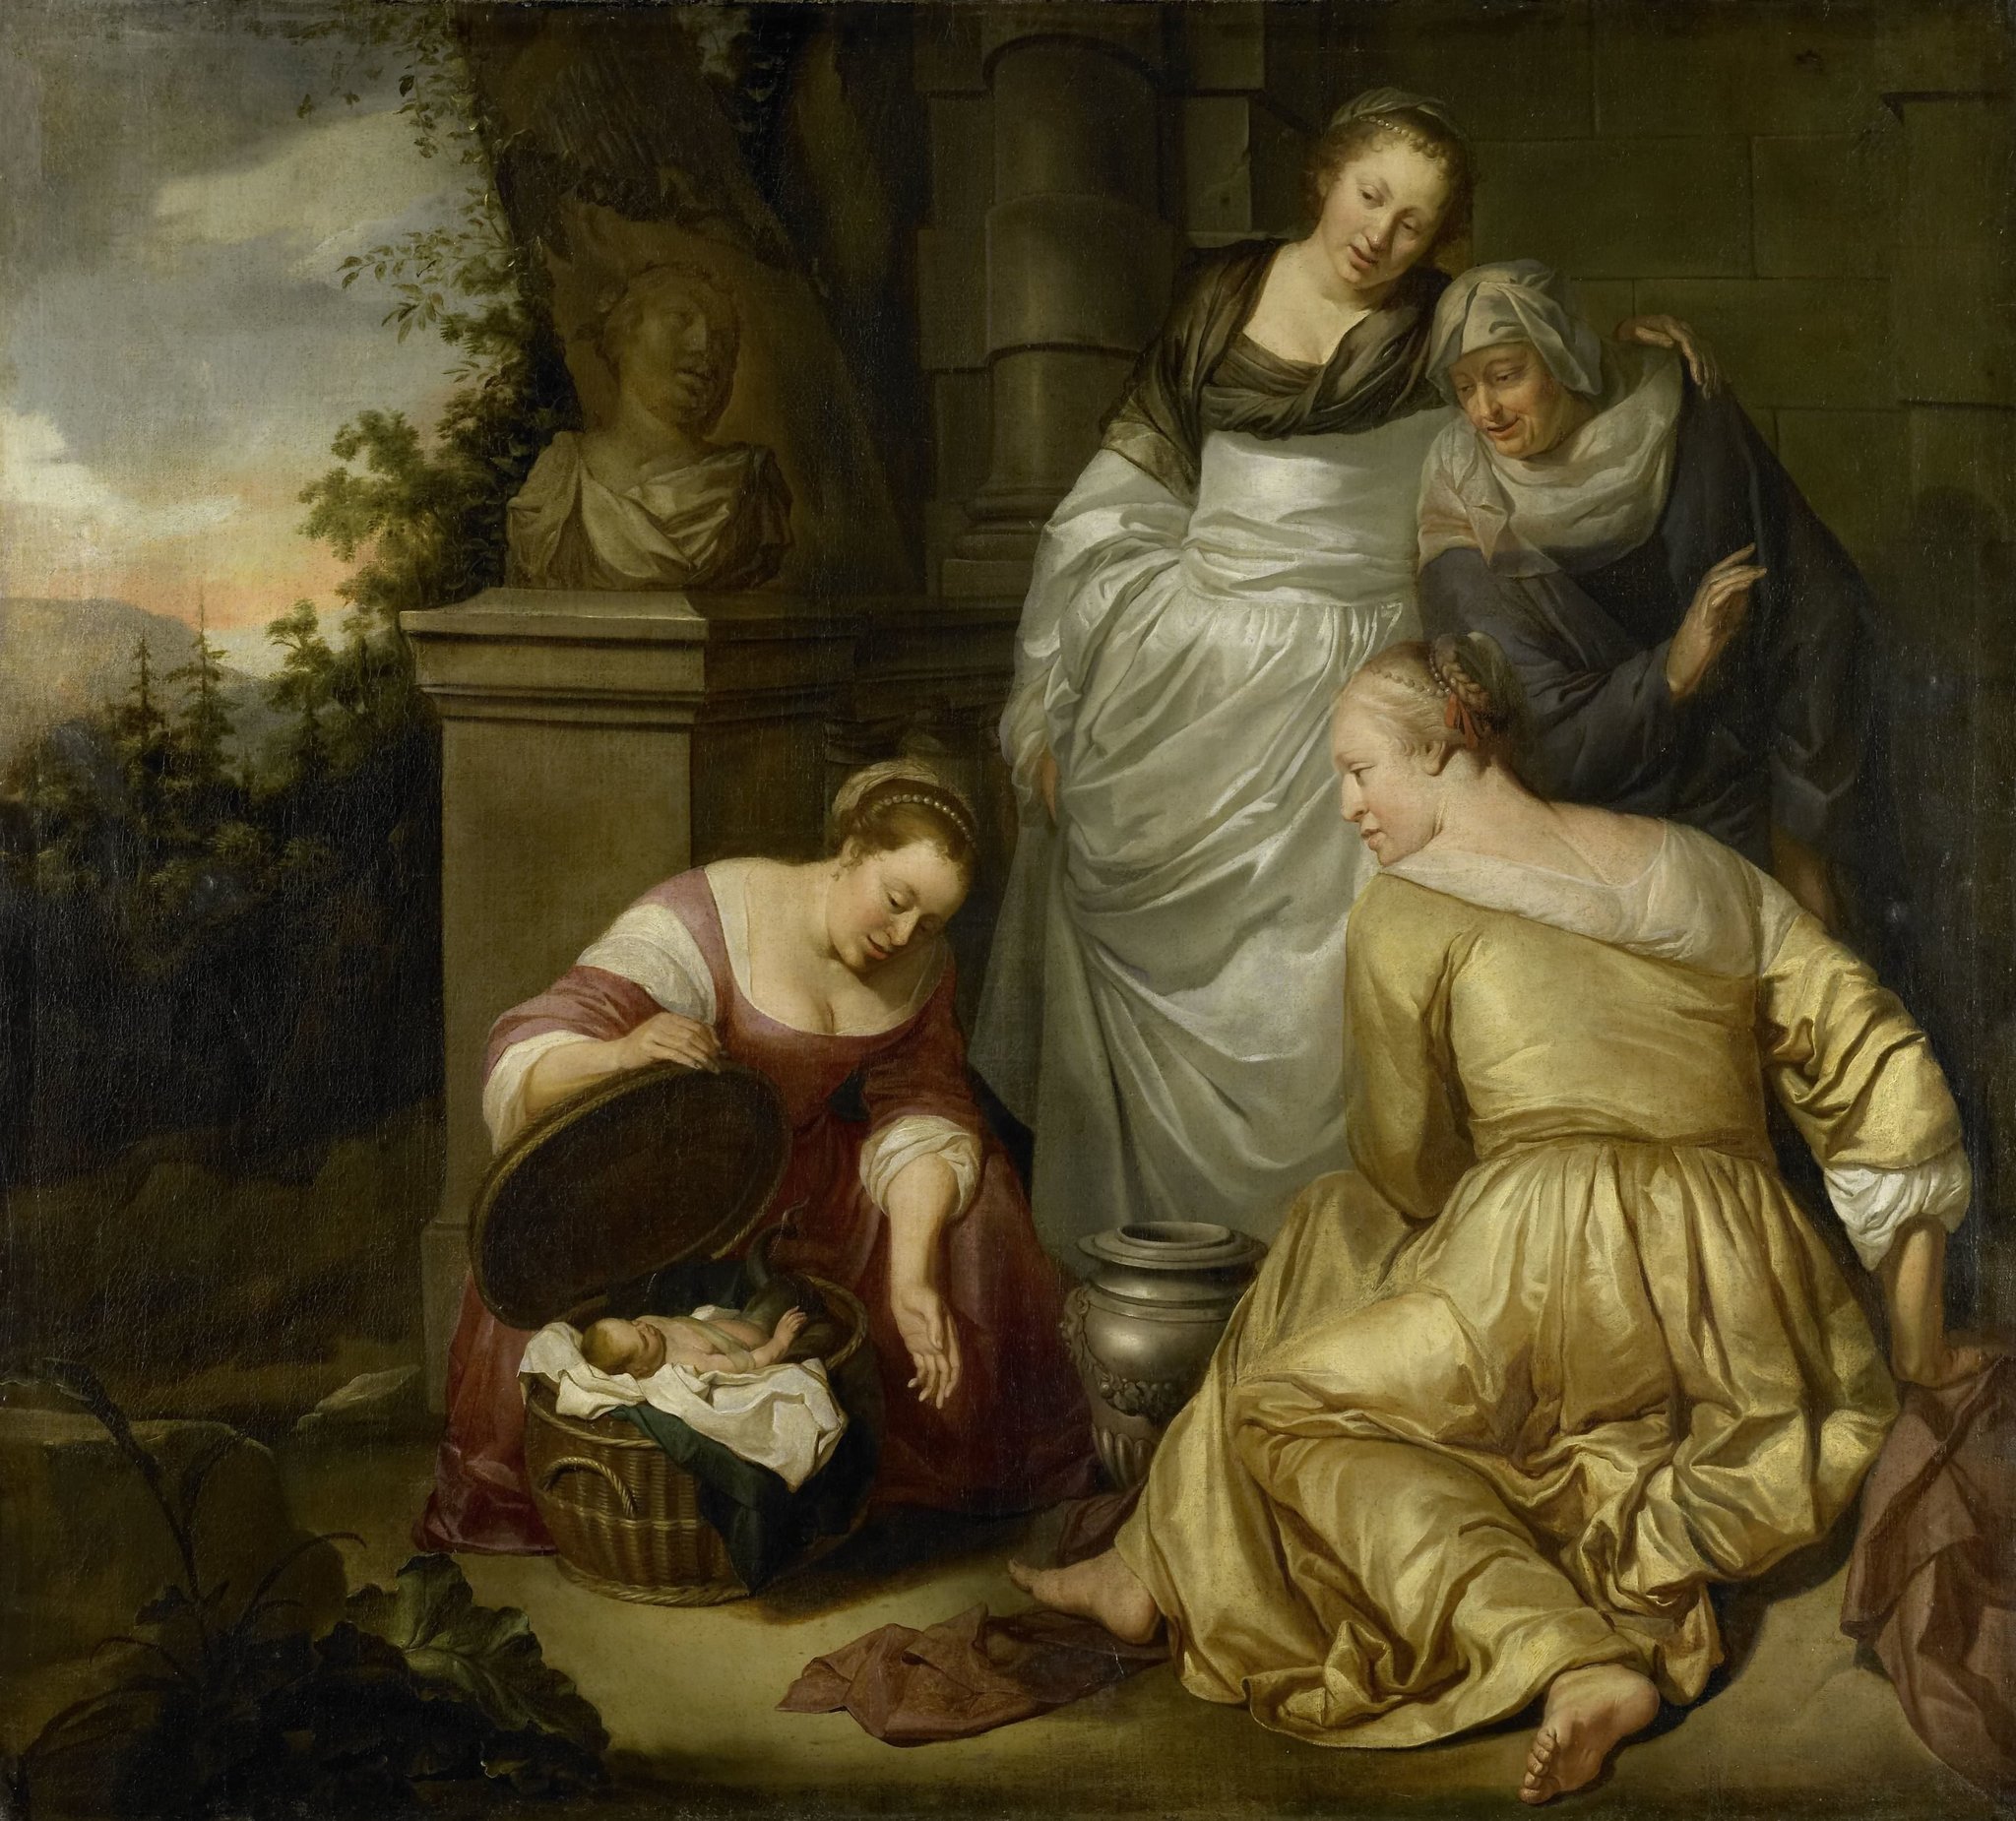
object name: painting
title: Erichthonius found by the daughters of Cecrops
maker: hendrick heerschop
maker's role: painter, print maker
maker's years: 1626-1690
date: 1650-1672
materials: canvas, oil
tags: 95a(erichthonius)1211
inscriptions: signature: ‘H.Heerschop’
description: De dochters van Cecrops vinden Erechthonius. Twee vrouwen knielen bij het kind dat in een rieten mand ligt. Het kind heeft deels het lijf van een slang. Rechts kijken een jonge en een oude vrouw toe. Op een stenen voetstuk staat een buste.